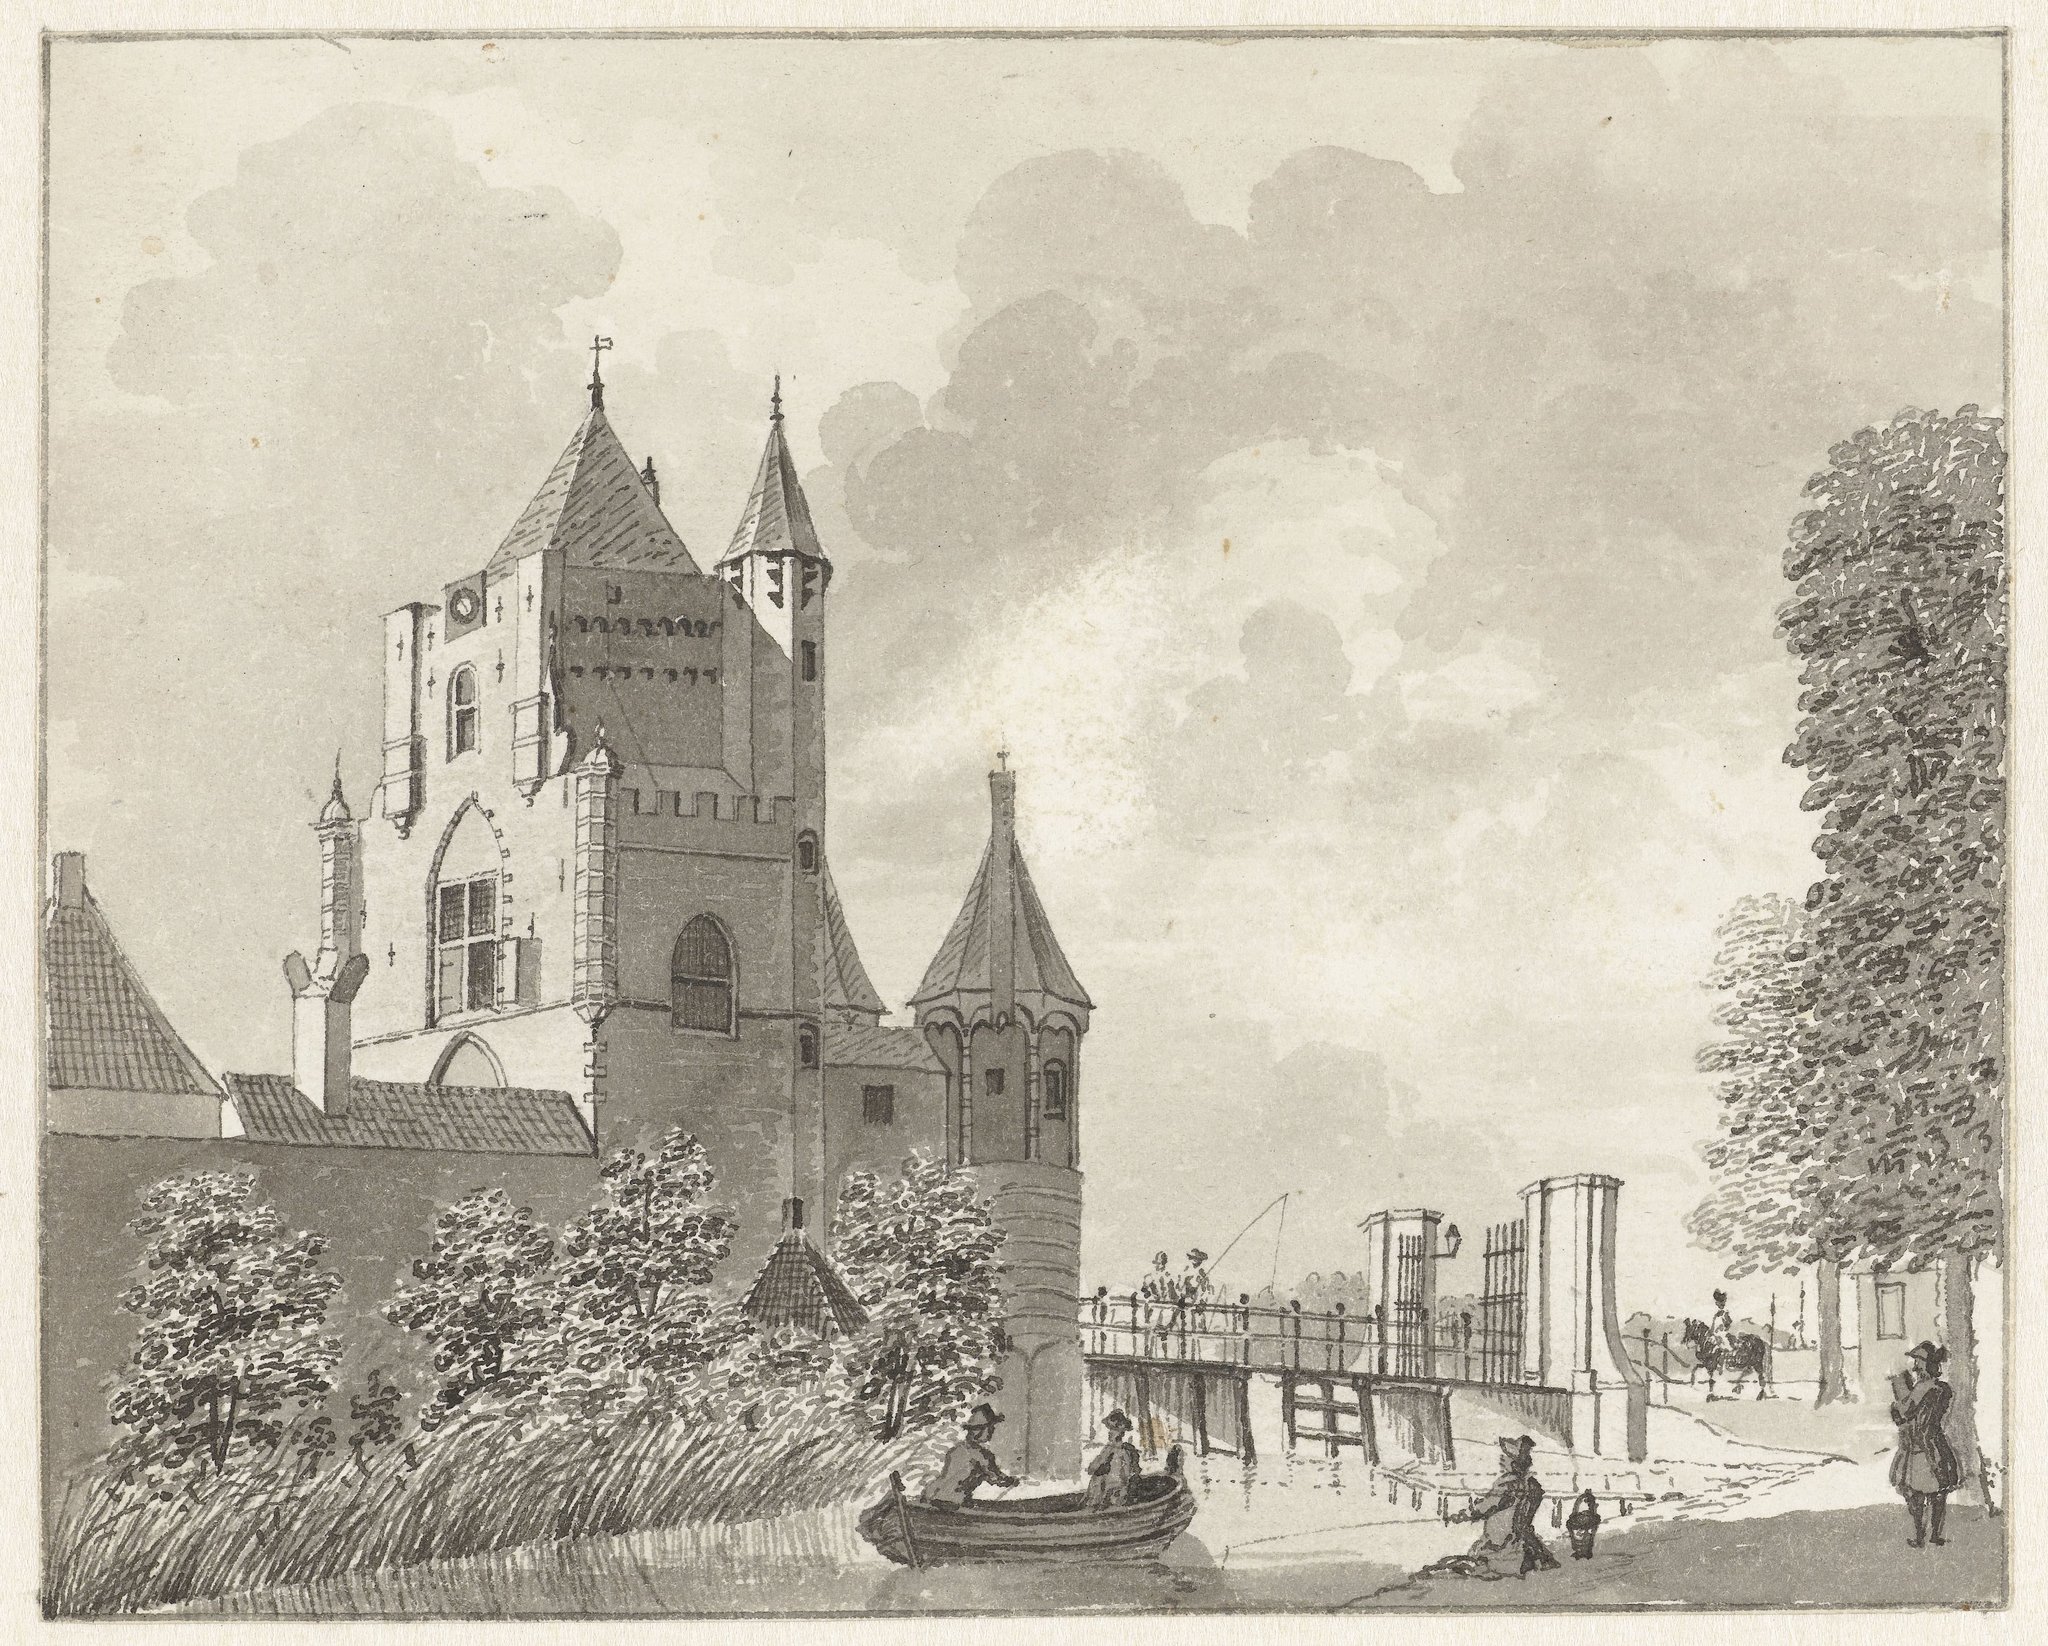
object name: drawing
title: De Spaarnwouder Poort te Haarlem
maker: hendrik spilman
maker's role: draughtsman, painter, print maker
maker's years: 1721-1784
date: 1733-1784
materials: ink, paper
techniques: brush, pen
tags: city-gate, haarlem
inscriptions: inscription: ‘de Sparewouder Poort te Haarlem’